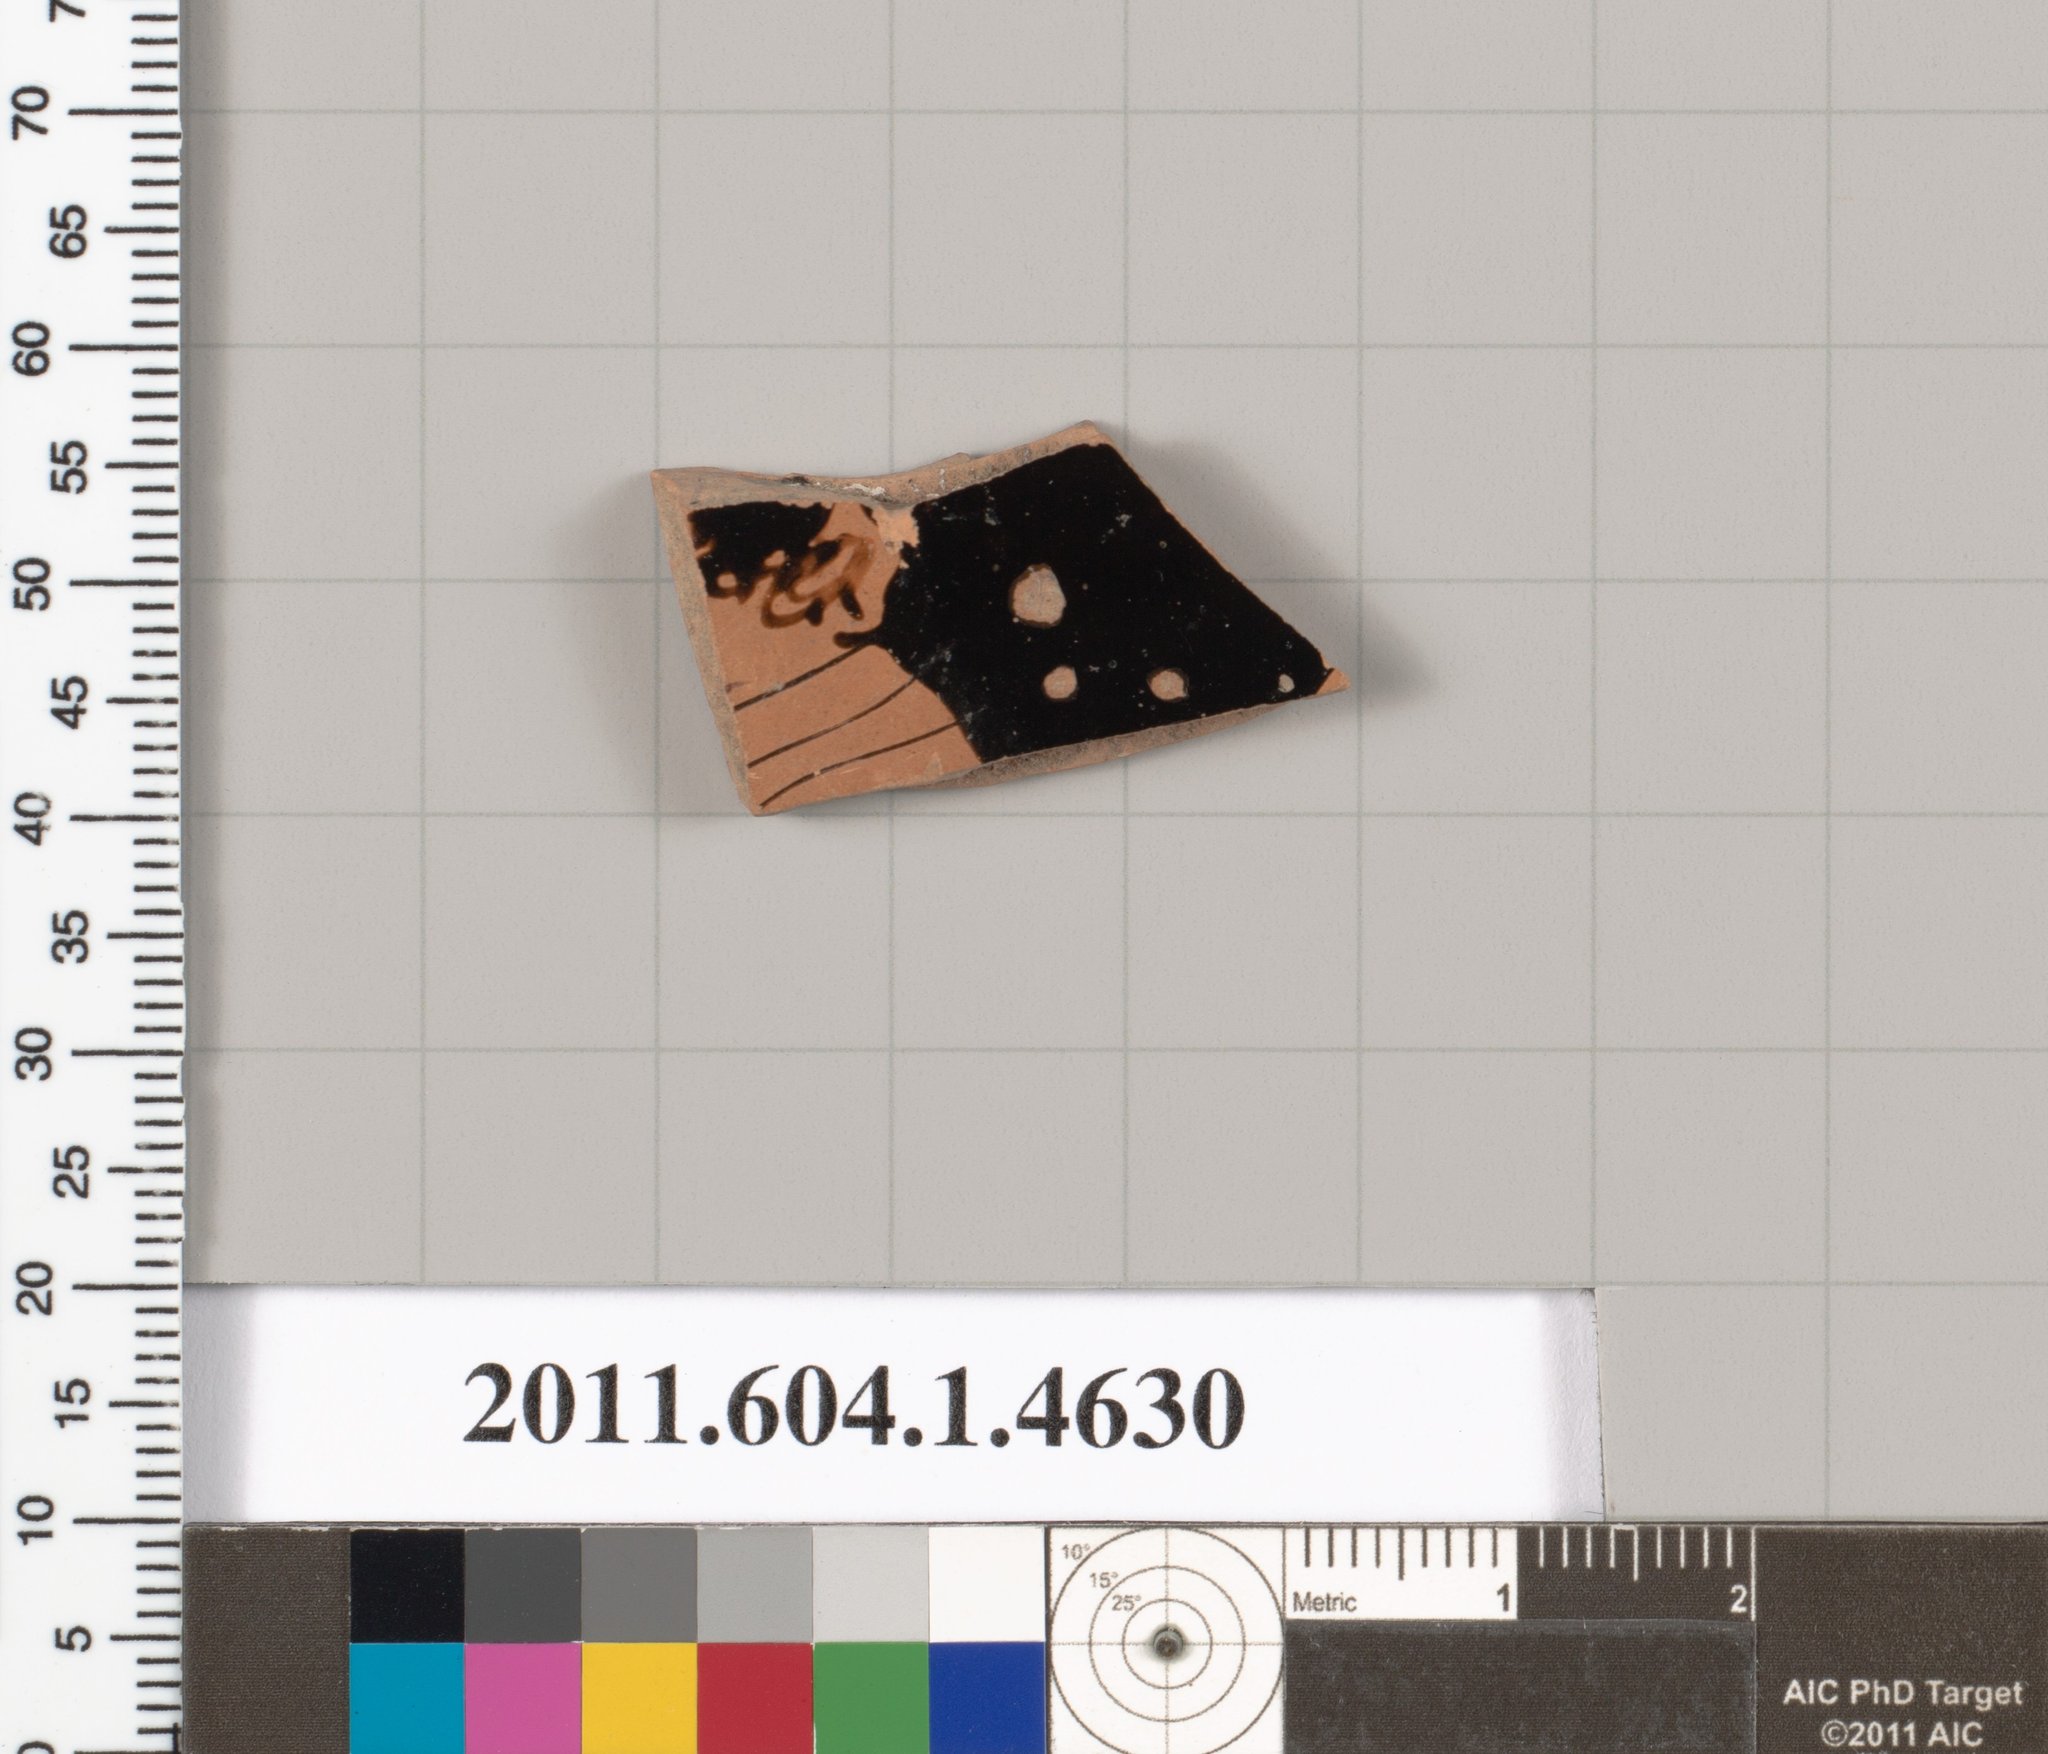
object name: kylix fragment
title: Terracotta fragment of a kylix (drinking cup)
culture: greek, attic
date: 460-450 BCE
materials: terracotta